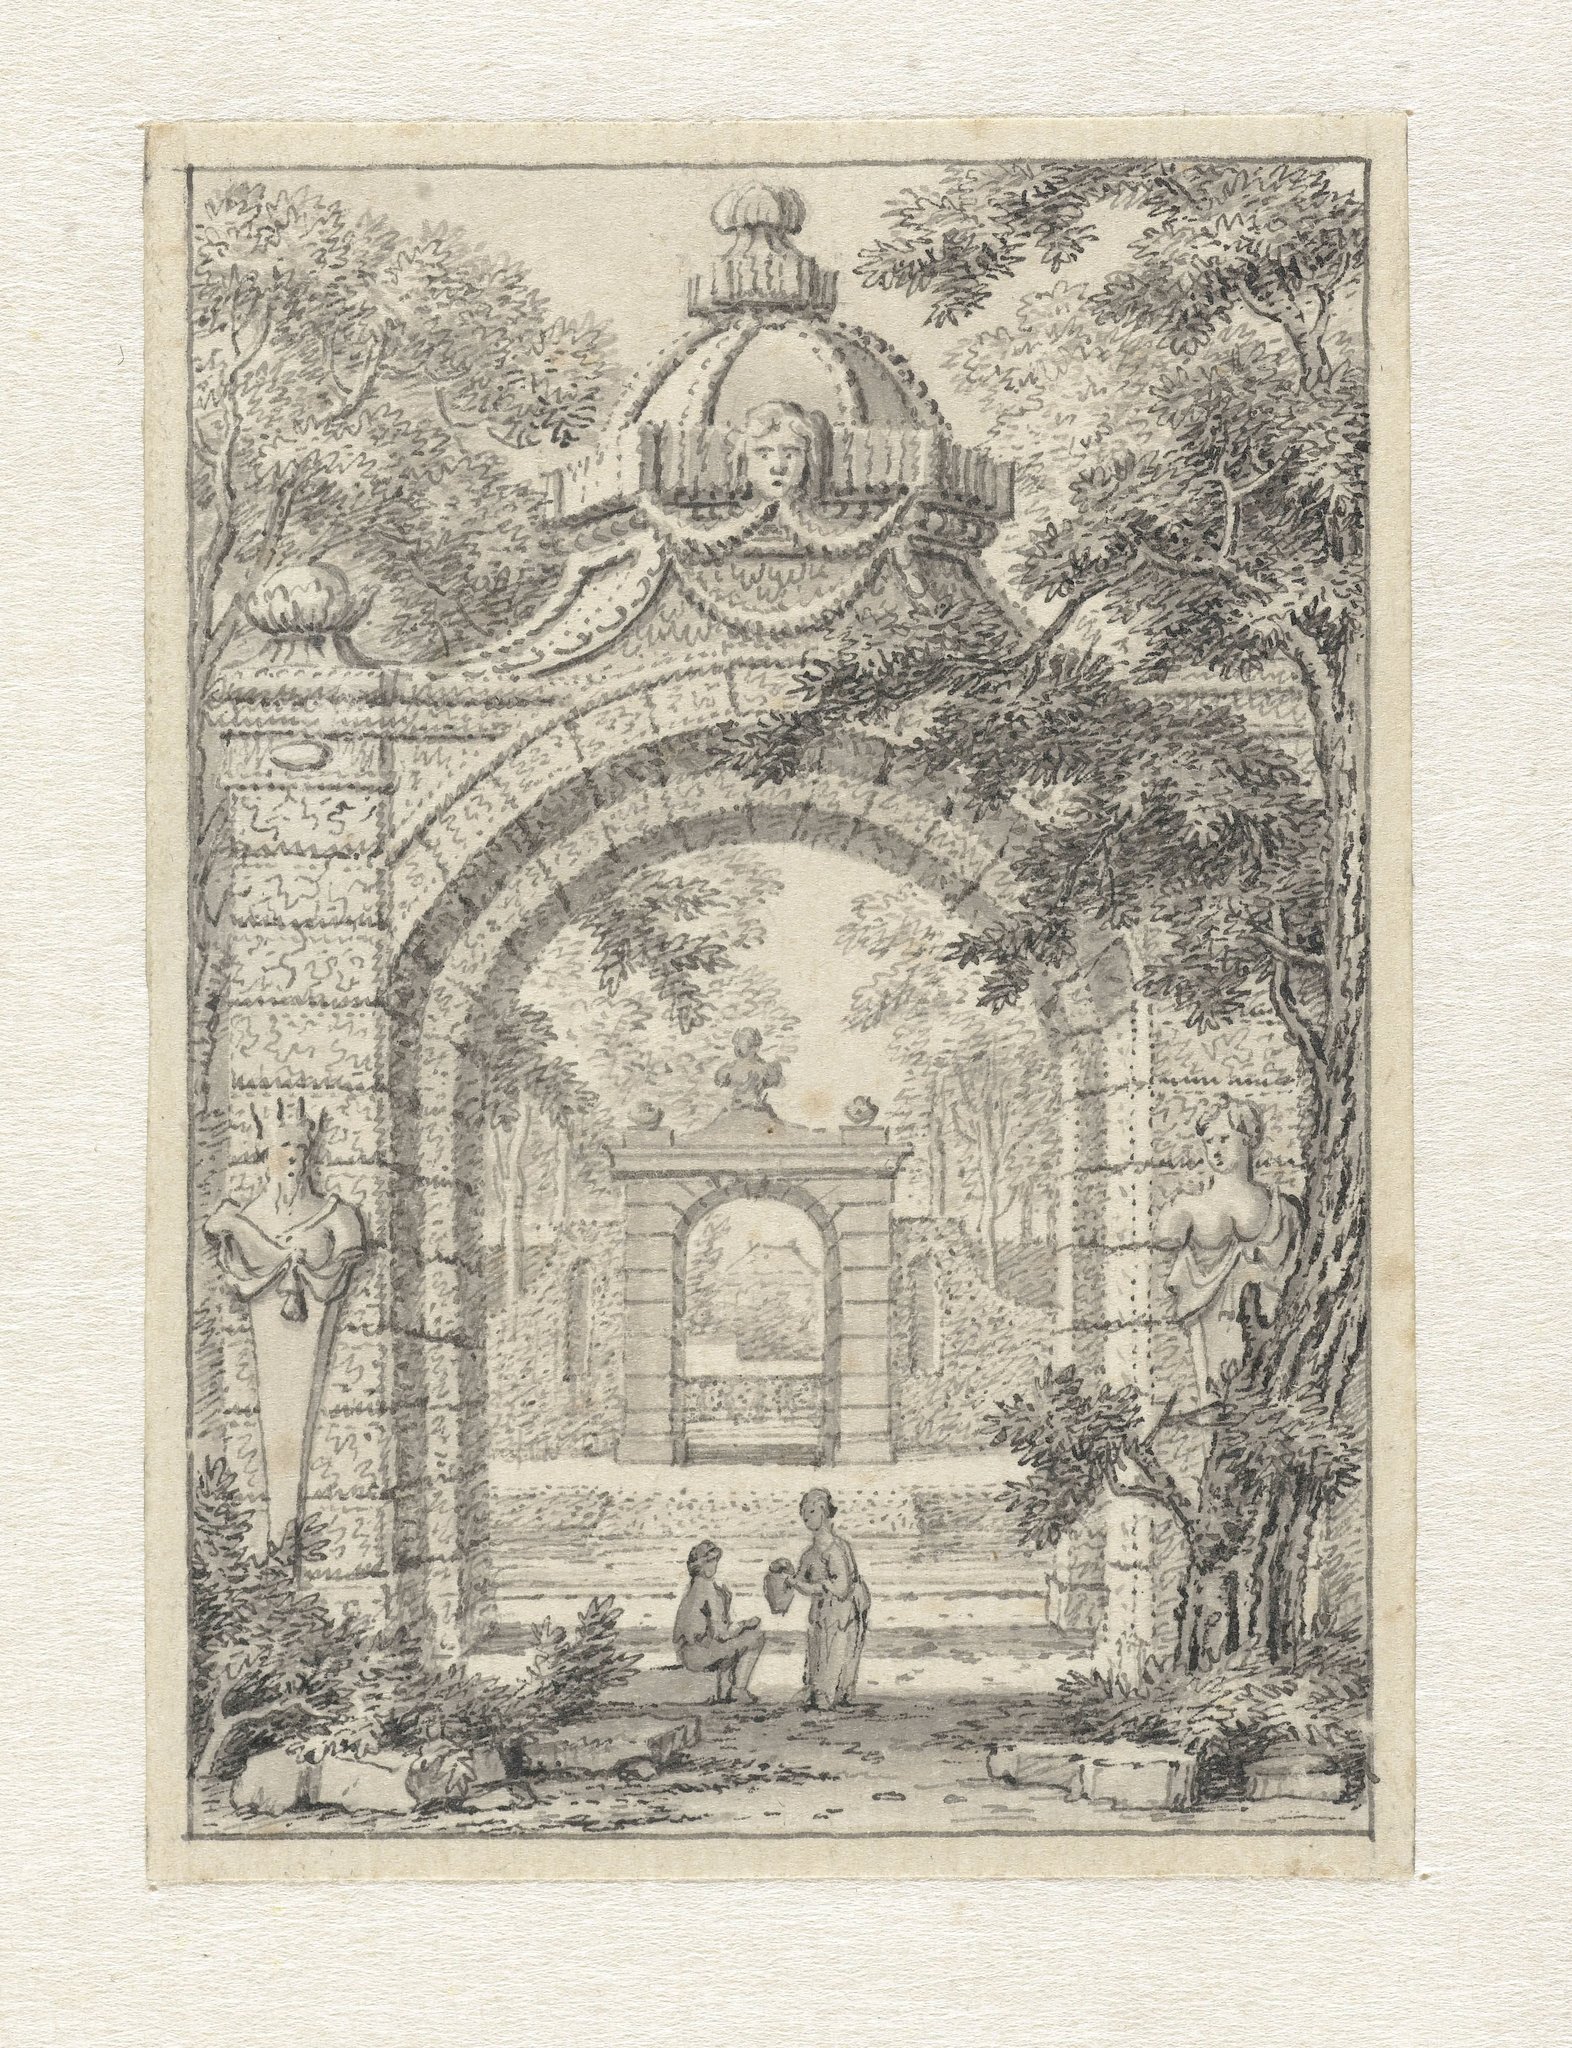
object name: drawing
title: Klein landschap met twee tuinpoorten achter elkaar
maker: johannes de bosch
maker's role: draughtsman, print maker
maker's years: 1713-1785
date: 1775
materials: ink, paper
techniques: brush, pen